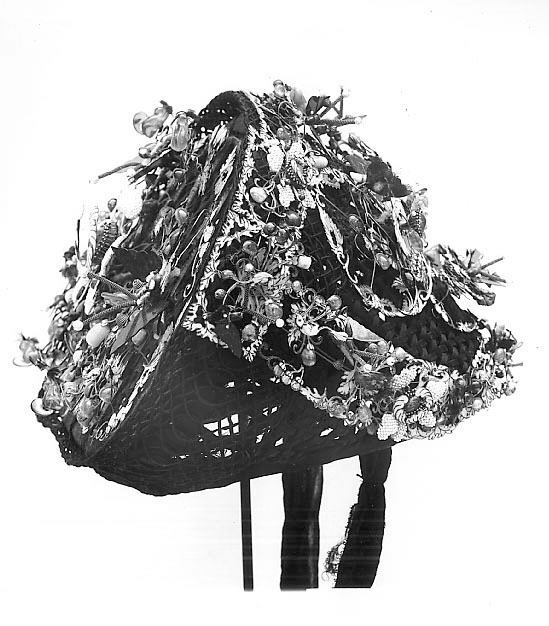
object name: court headdress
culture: chinese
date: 1701-1900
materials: gilt, gold, metal, stone